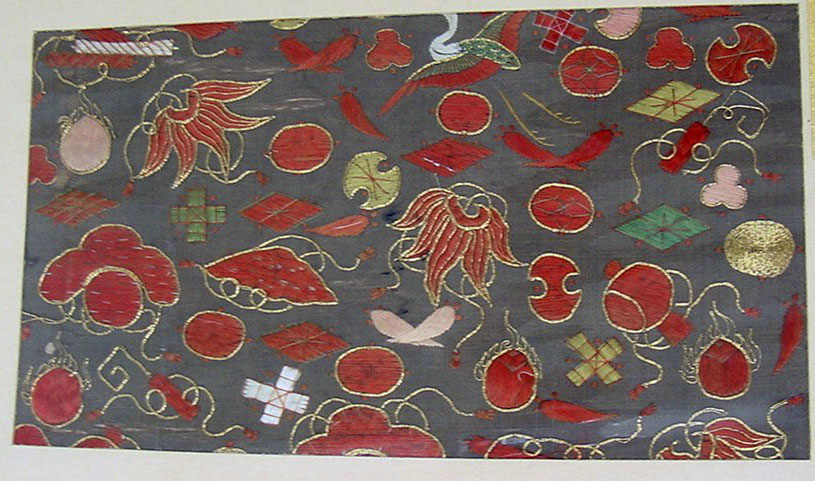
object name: piece from a kosode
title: Piece from a Kosode with Auspicious Treasures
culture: japanese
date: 1615-1868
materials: metal thread, silk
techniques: embroidery, weave